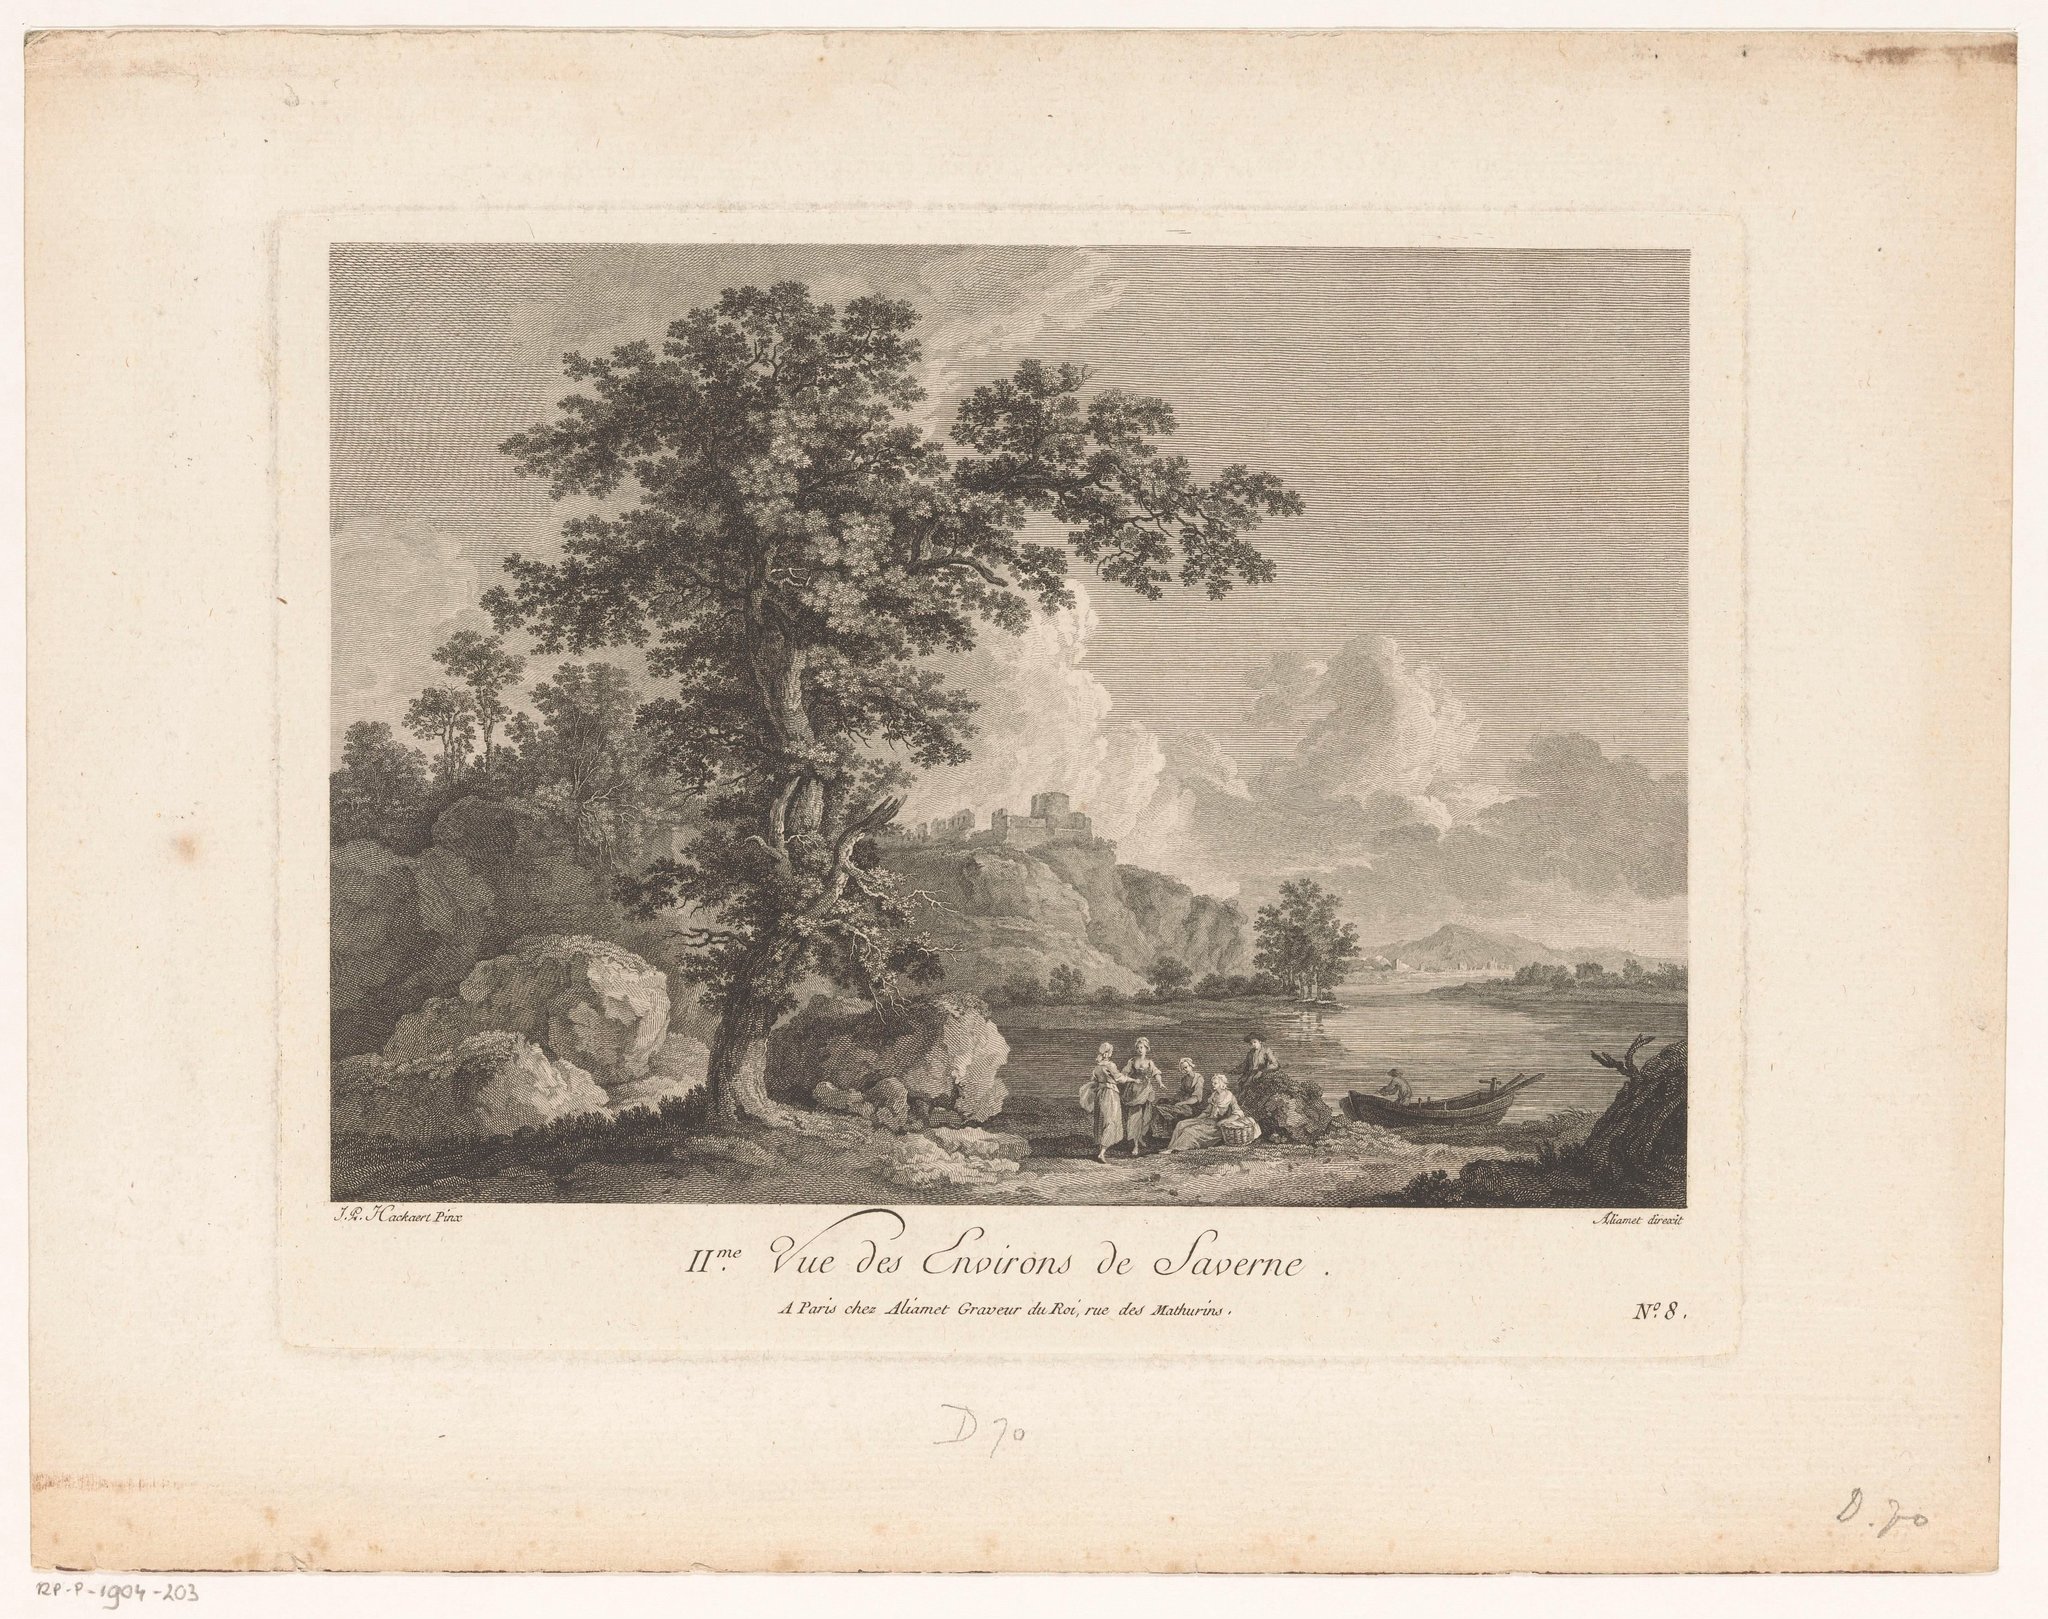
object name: print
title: IIme vue des environs de Saverne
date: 1750-1788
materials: paper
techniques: engraving, etching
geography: france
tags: trees, landscapes, river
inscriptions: collector's mark: Lugt 2228, inscription: ‘f 2.-.- [?]’